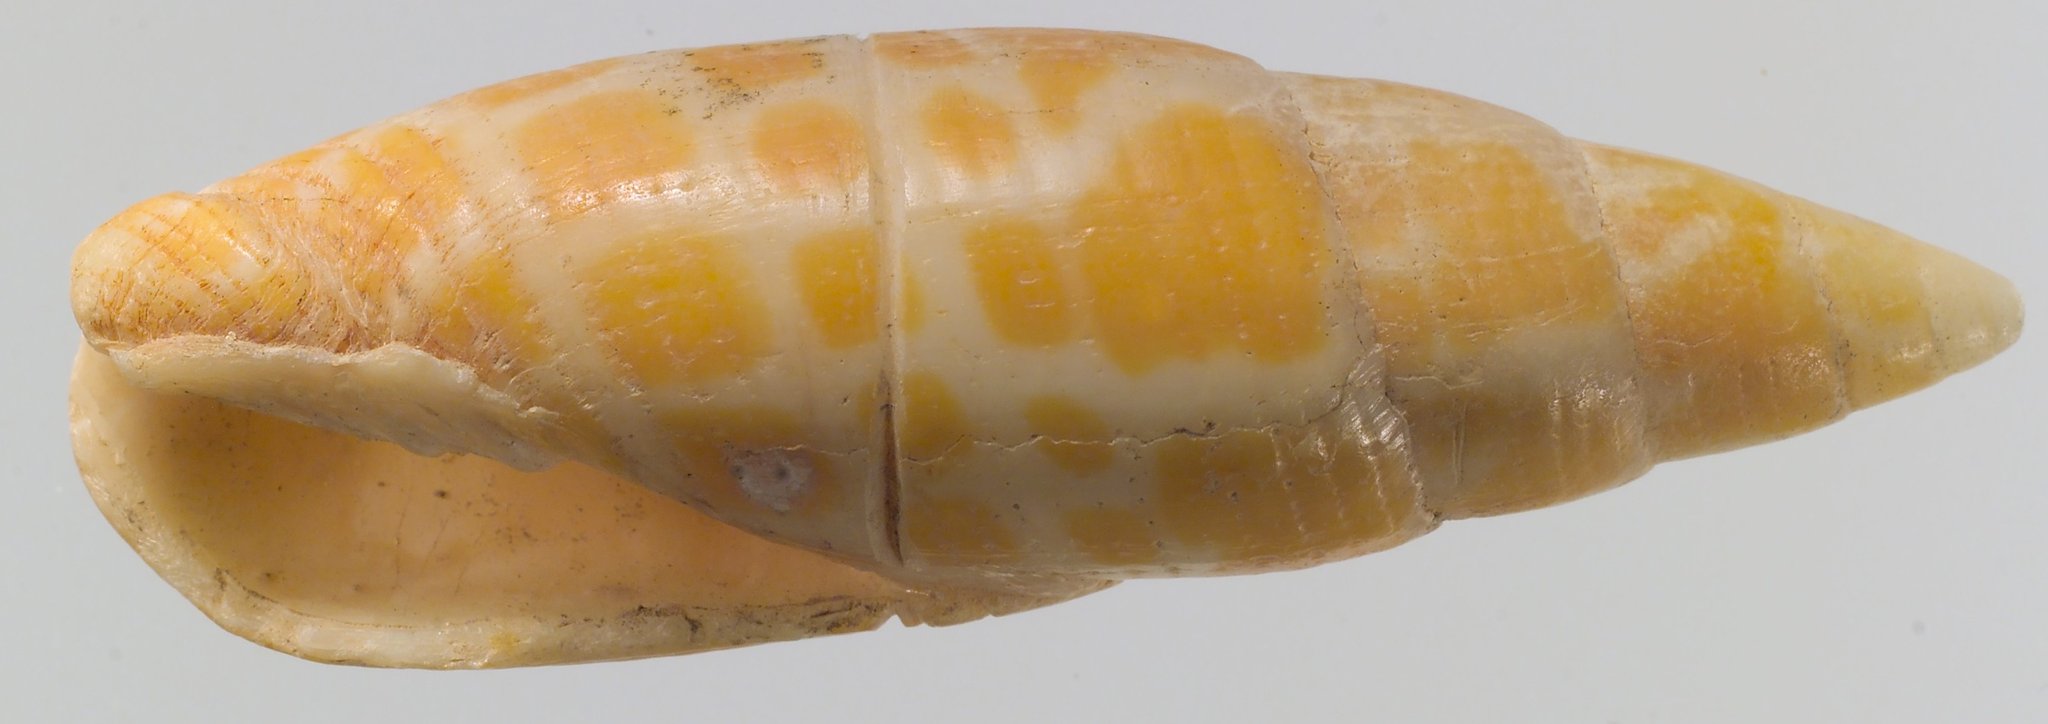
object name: shell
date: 2900-2350 BCE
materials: shell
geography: mesopotamia